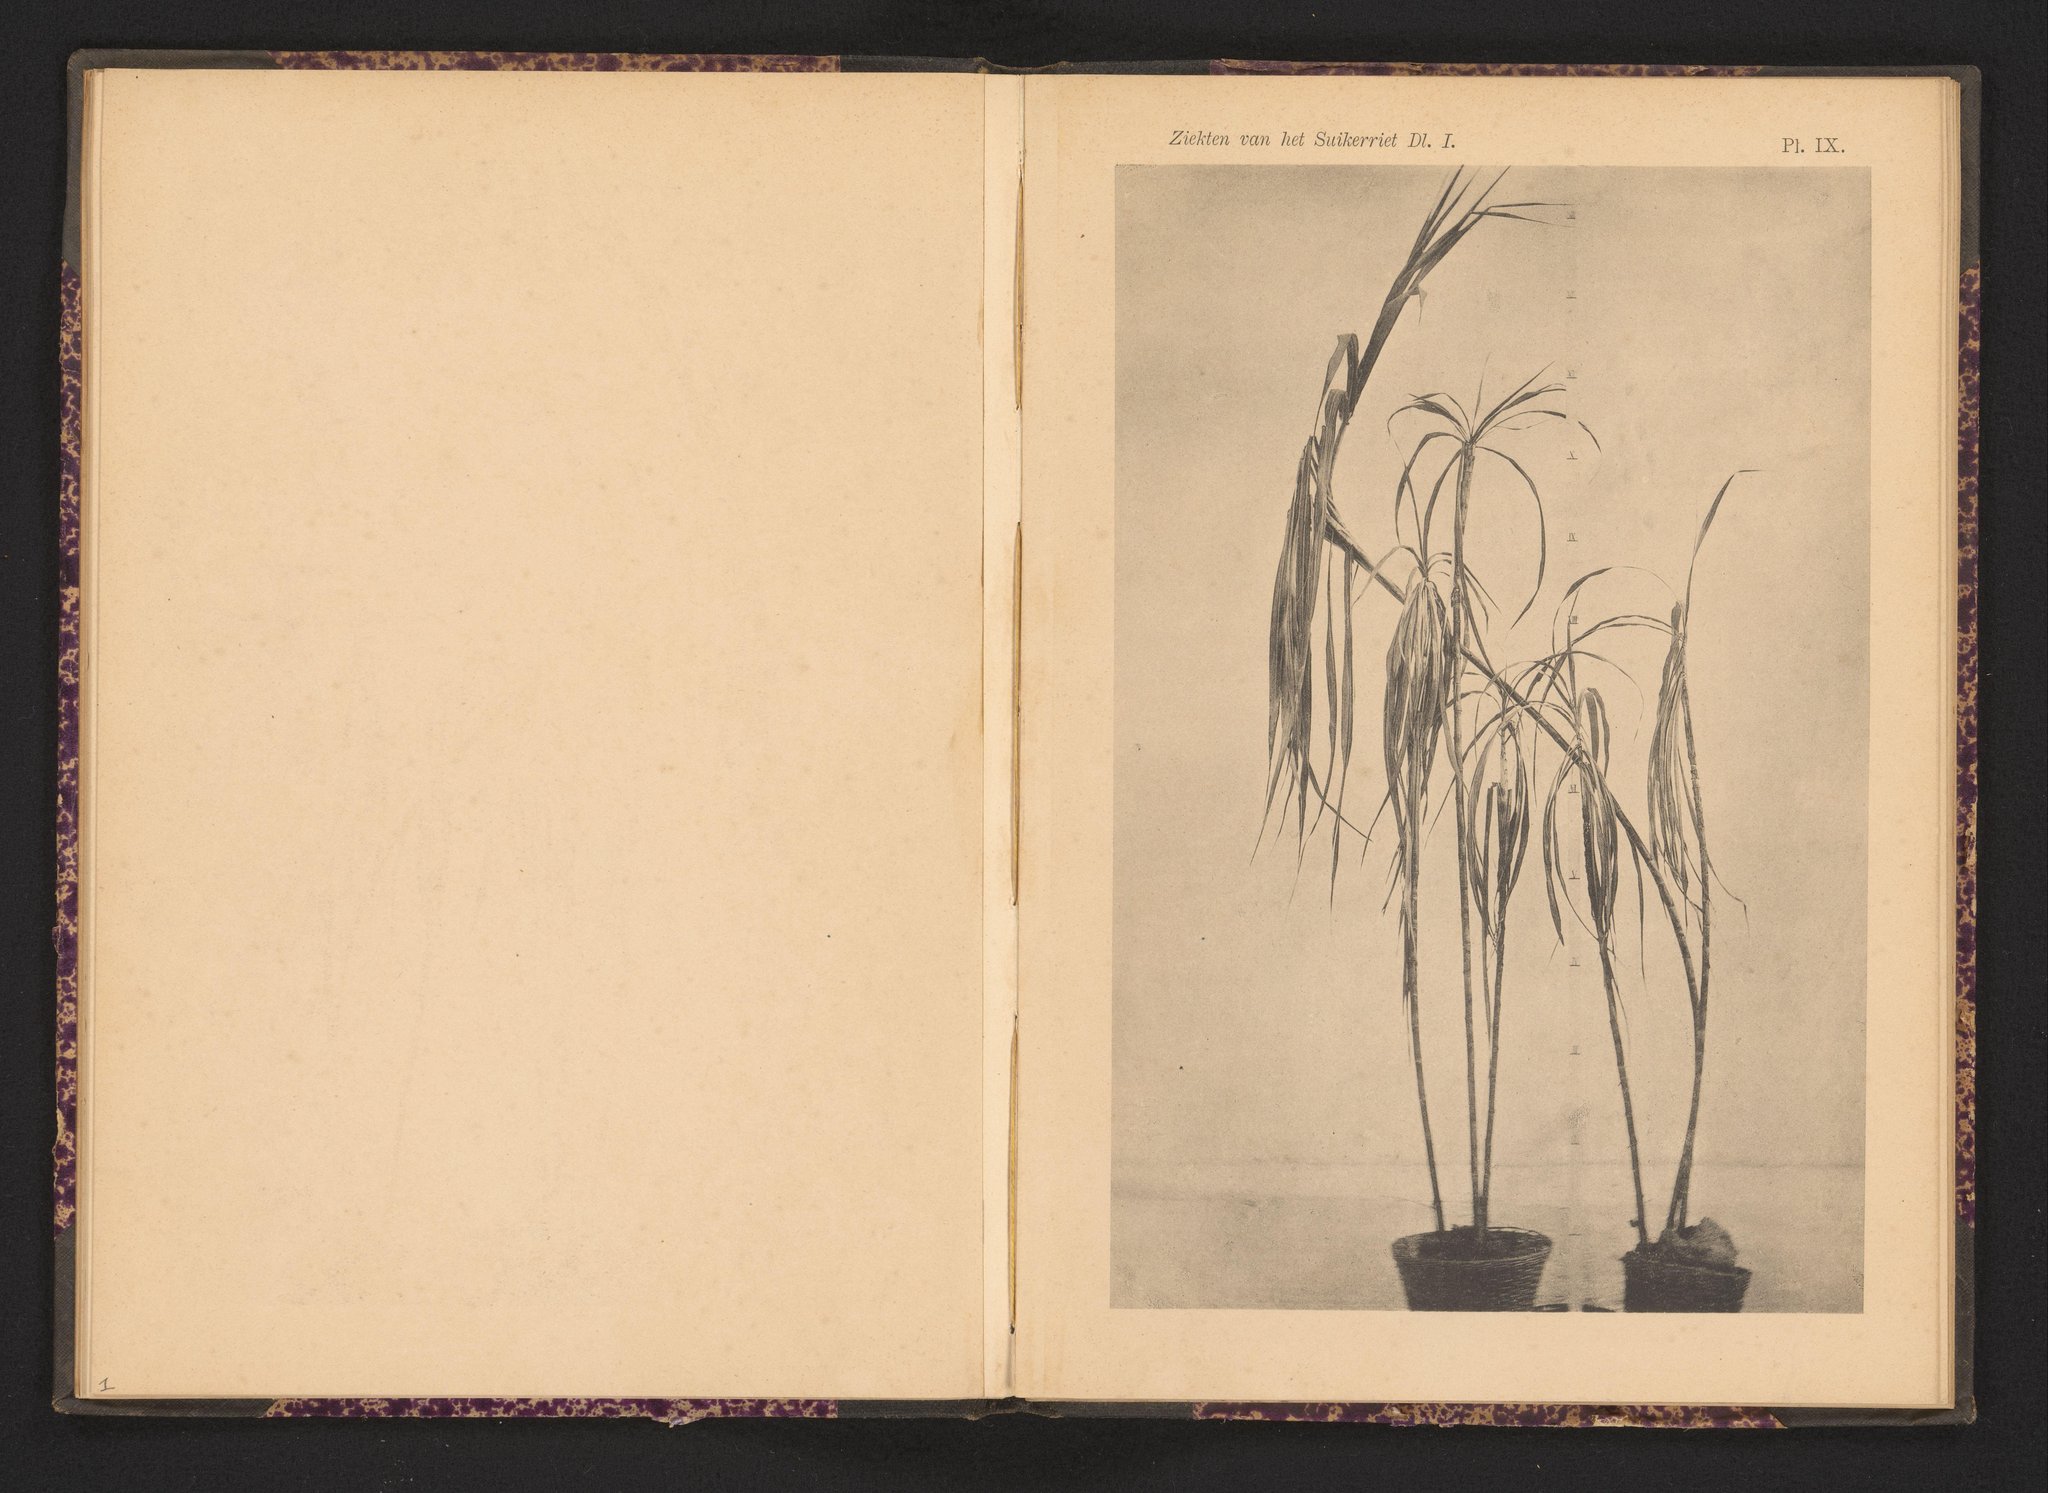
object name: photomechanical print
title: Twee suikerrietplanten die zijn aangetast door de Serehziekte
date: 1888-1898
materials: paper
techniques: photograph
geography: java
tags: plants; vegetation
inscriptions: number: ‘Pl. IX.’